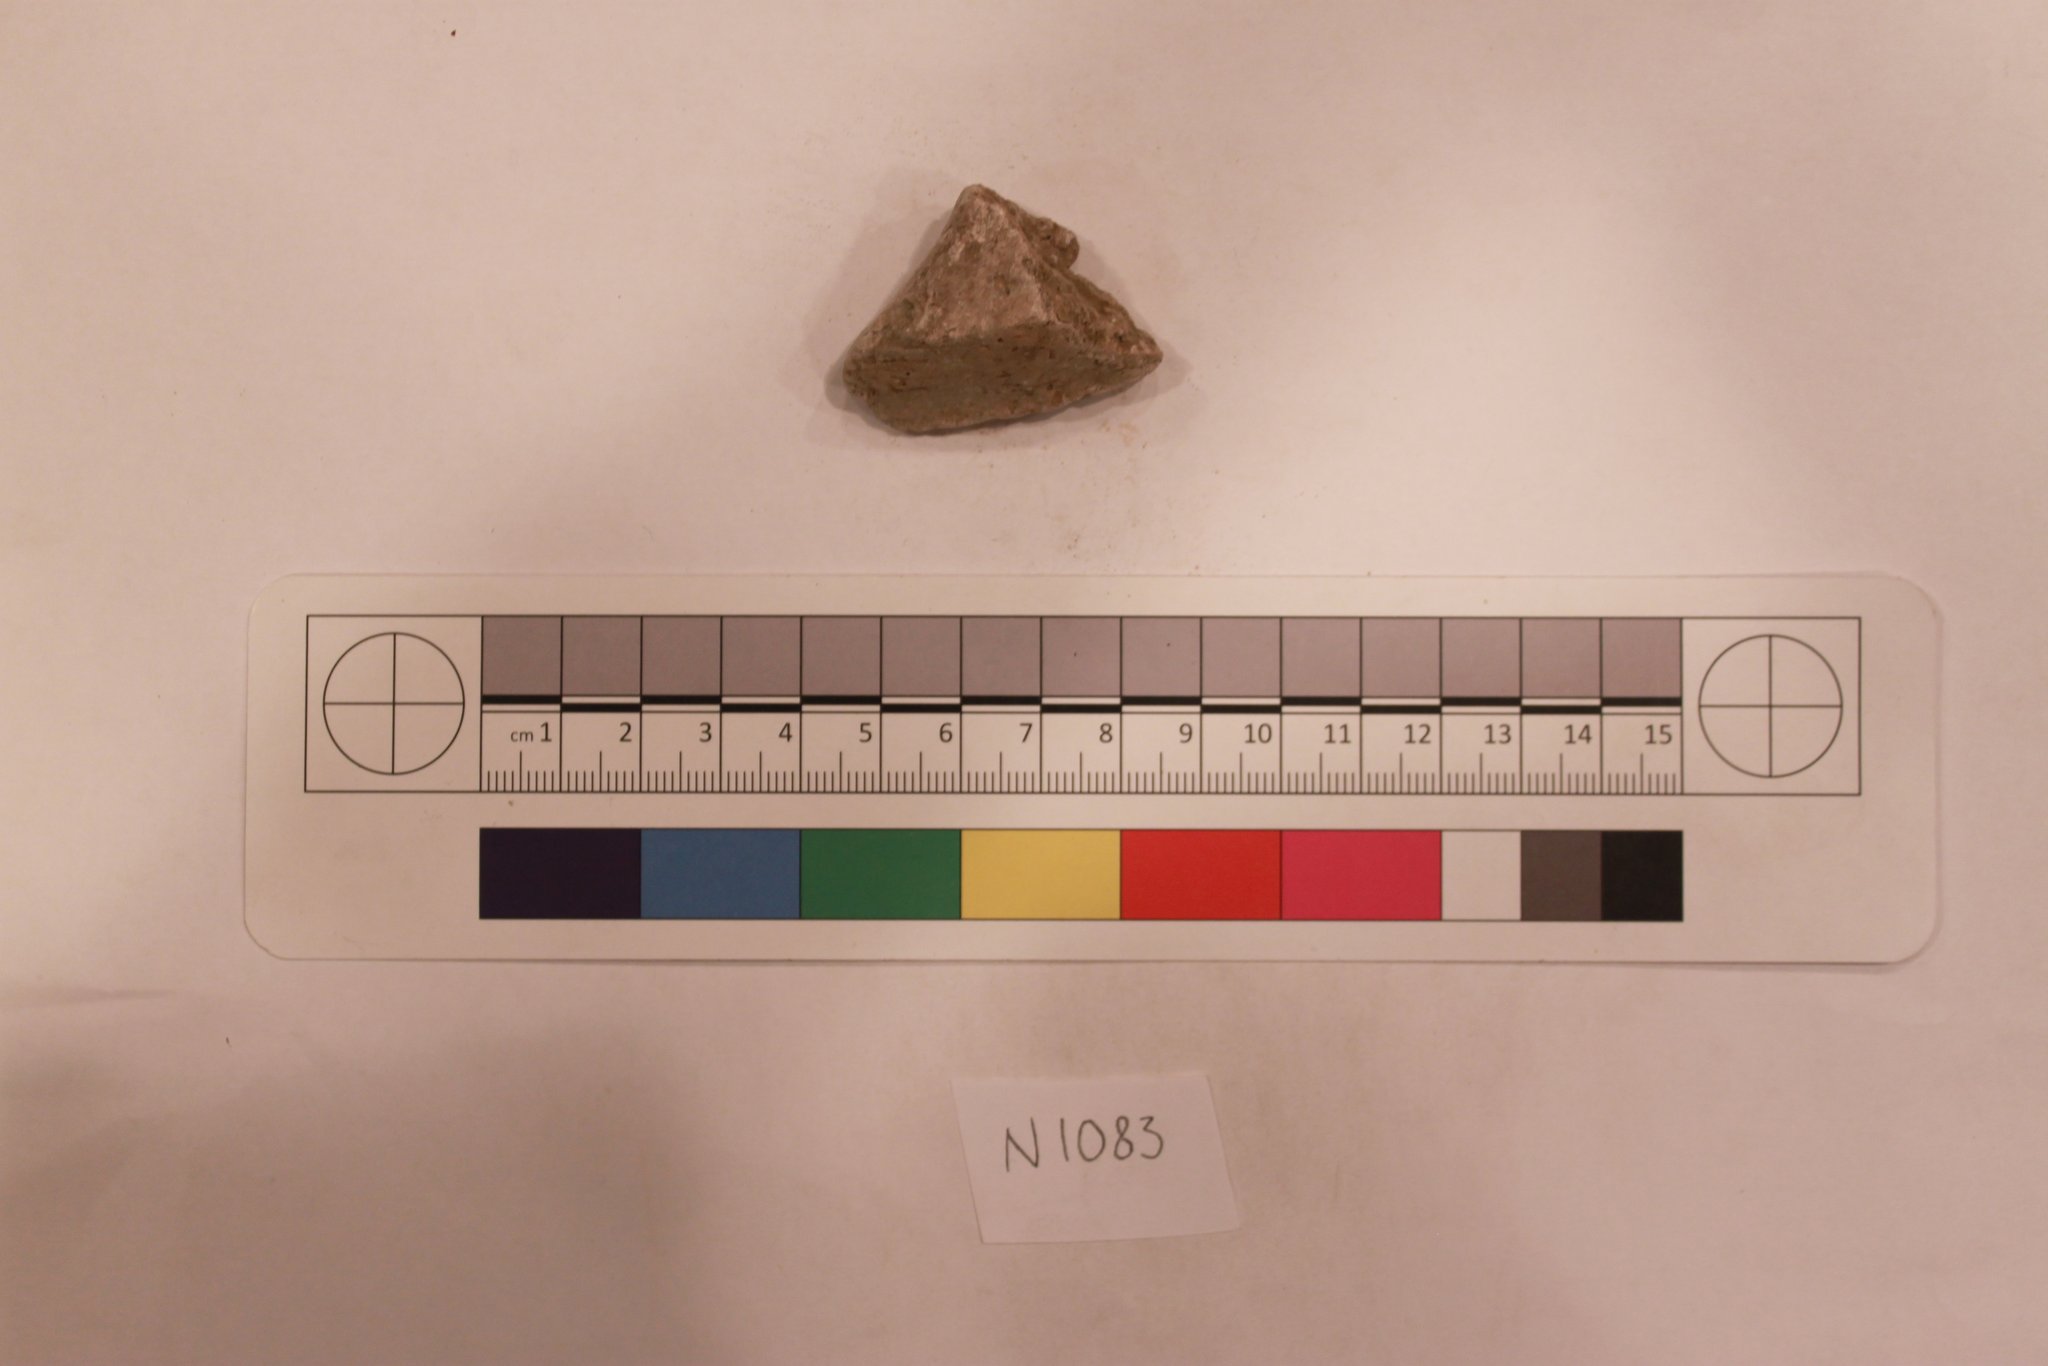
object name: fragment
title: Stucco Fragment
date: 701-1200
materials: plaster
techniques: carving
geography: iran